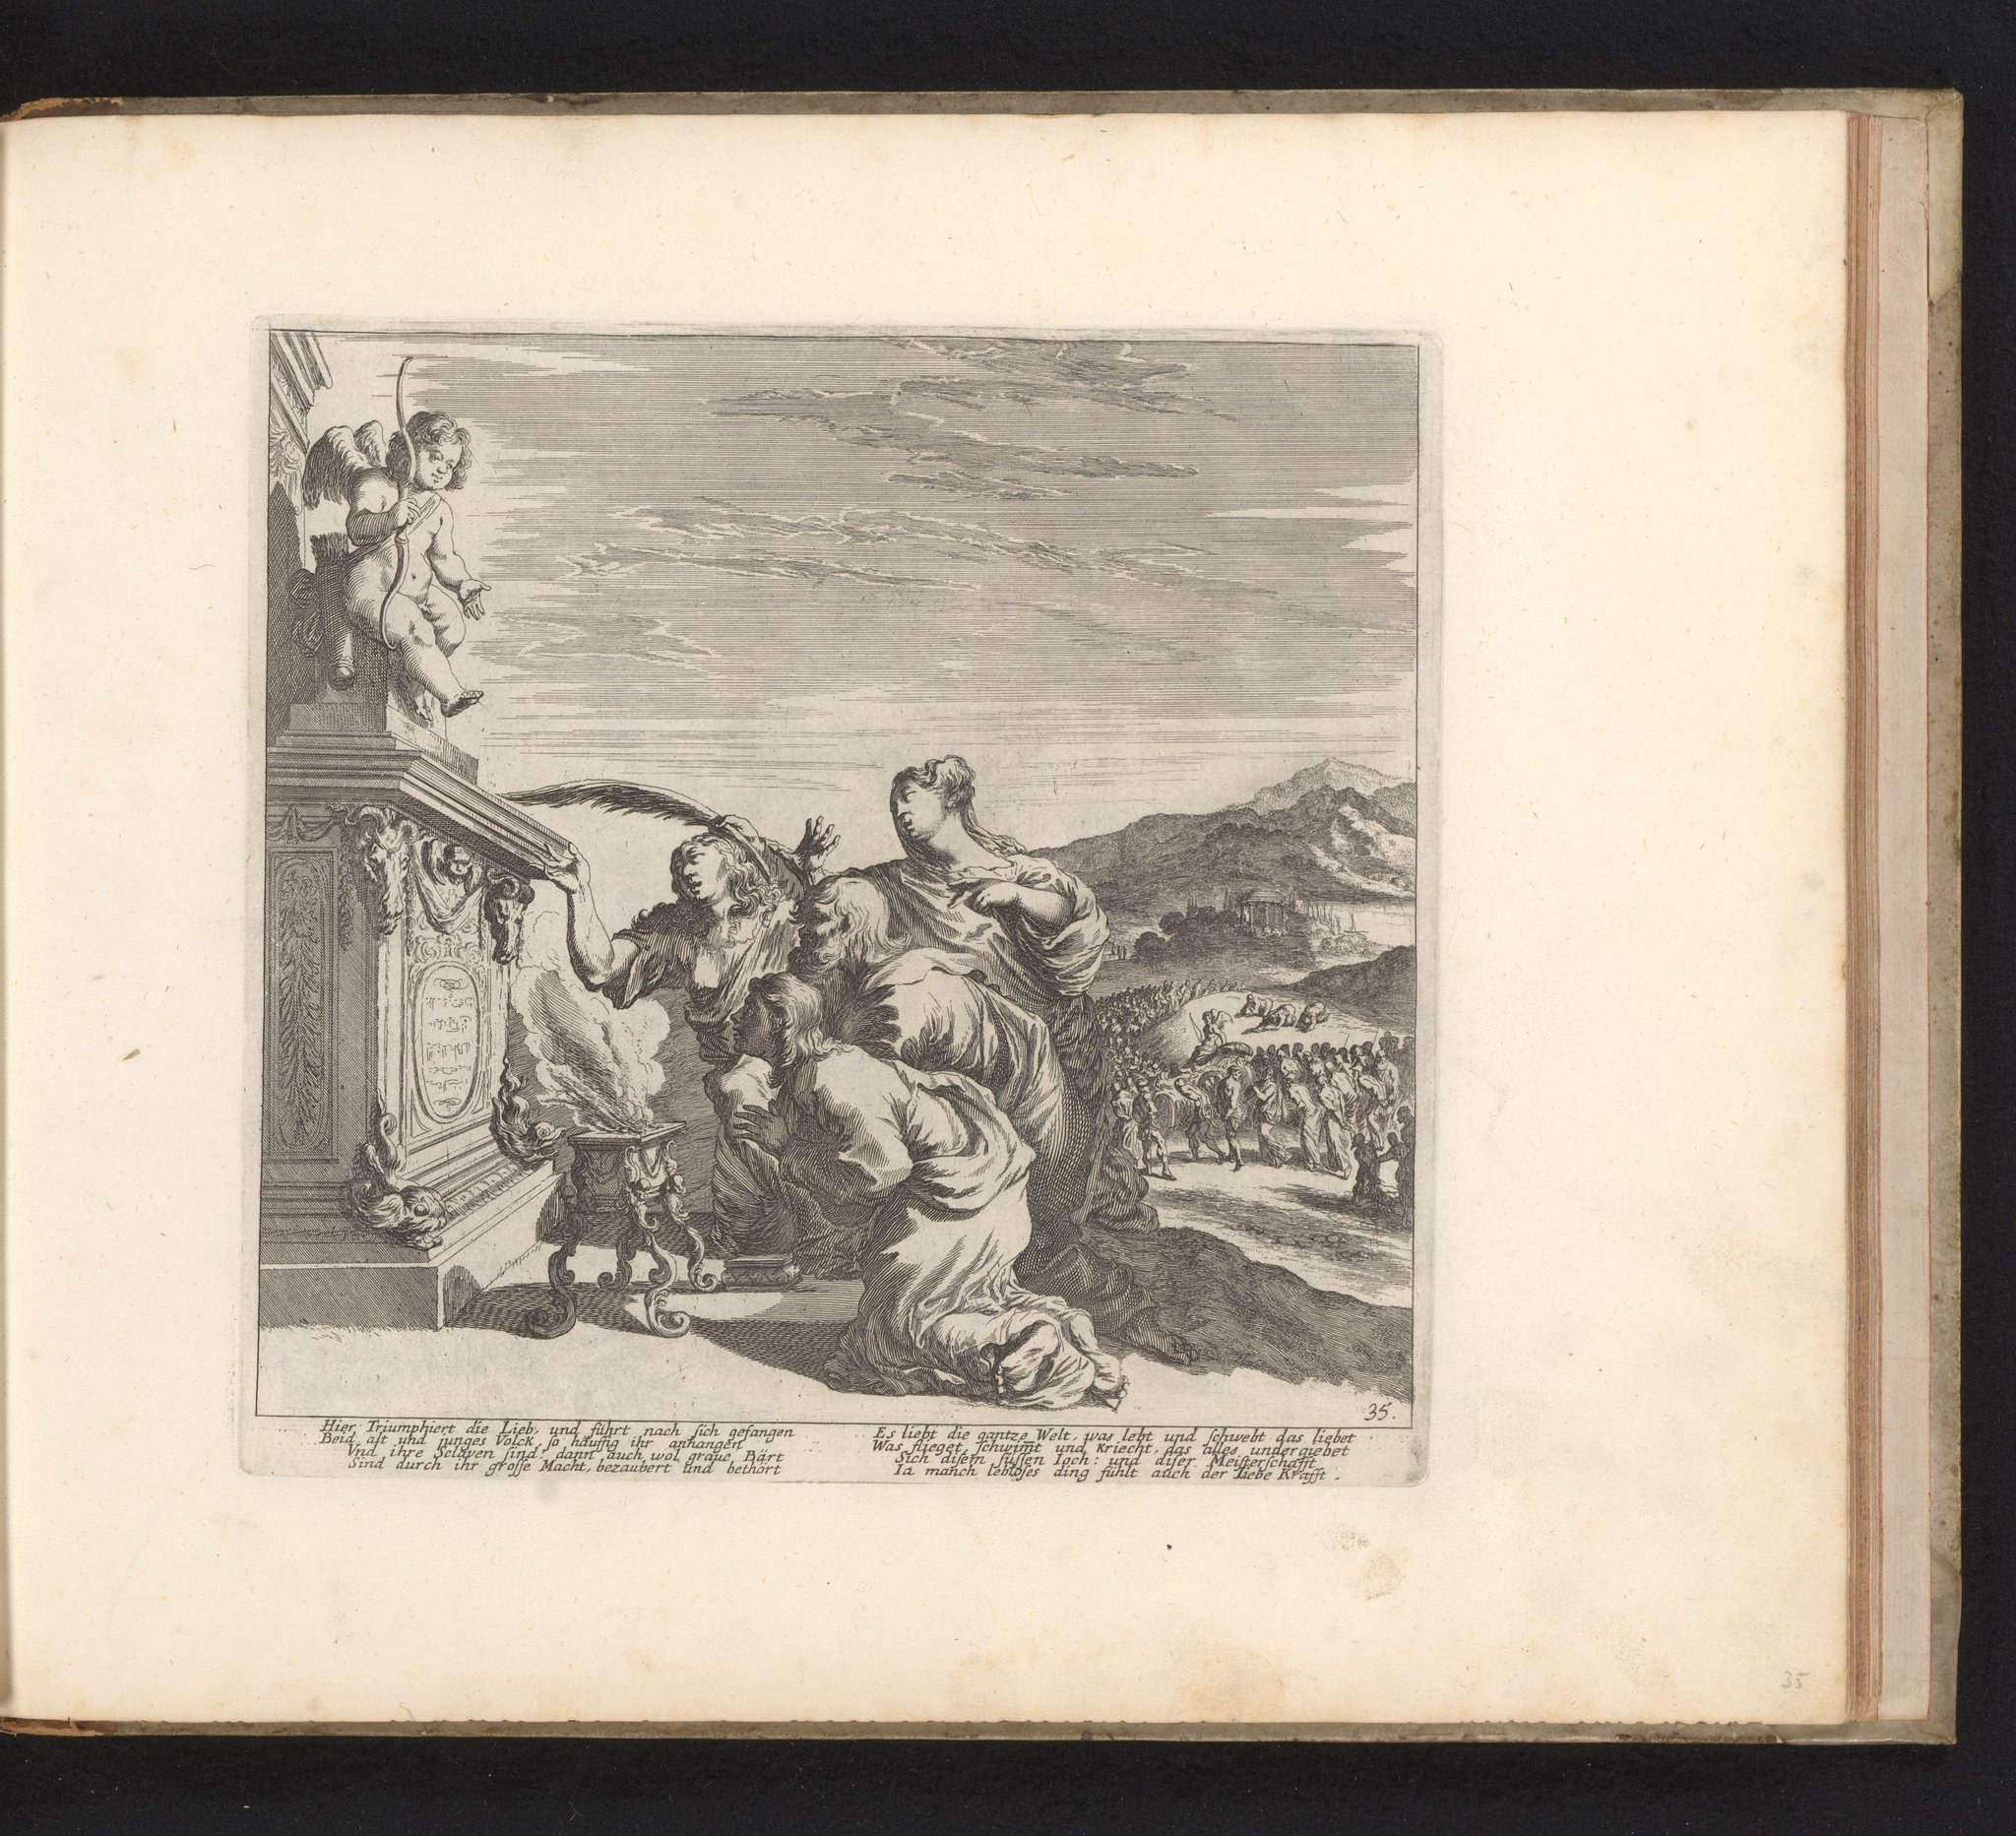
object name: print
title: Allegorie op de belofte van liefde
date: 1670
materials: paper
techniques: etching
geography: augsburg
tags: forza dell'amore, forza d'amore si nell'acqua come in terra' (ripa)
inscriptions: collector's mark: Lugt 2228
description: Deze prent hoort bij een reeks (RP-P-1963-360 t/m RP-P-1963-372) van allegorische figuren, deugden en ondeugden in het album: Johann Wilhelm Baur, Iconographia, 1682.